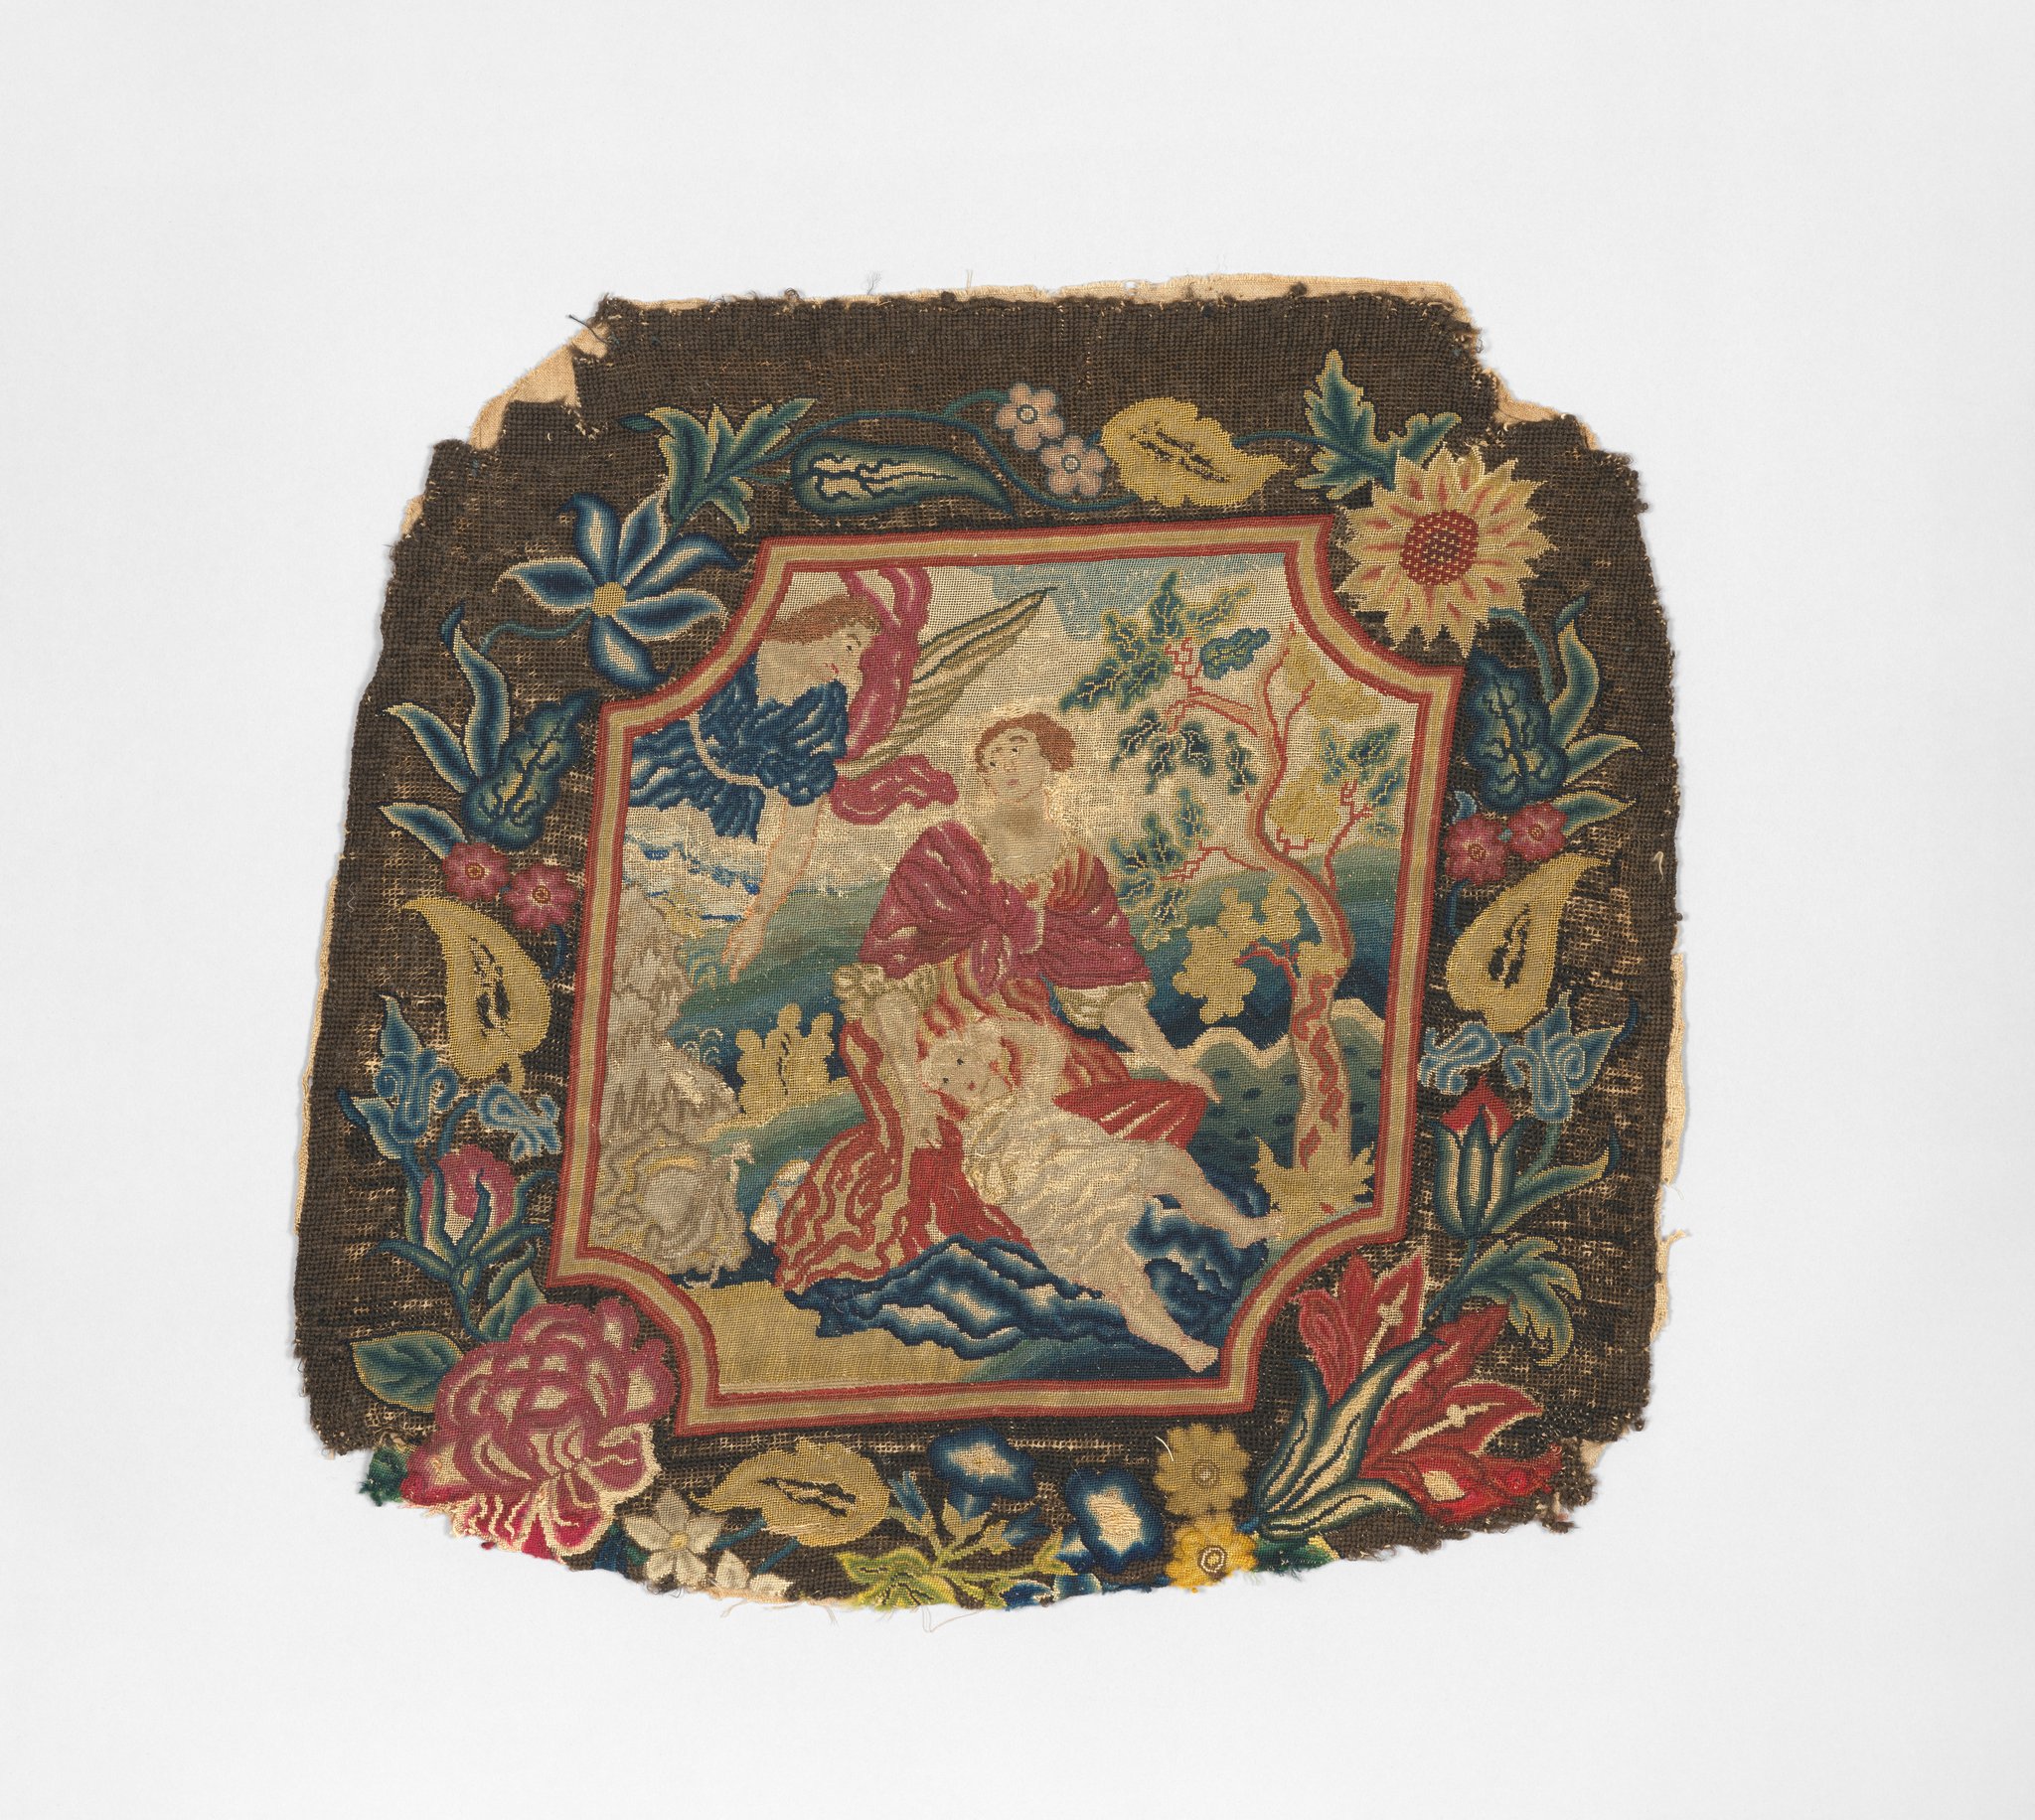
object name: cover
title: Chair seat cover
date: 1734-1766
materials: canvas, silk, wool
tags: women